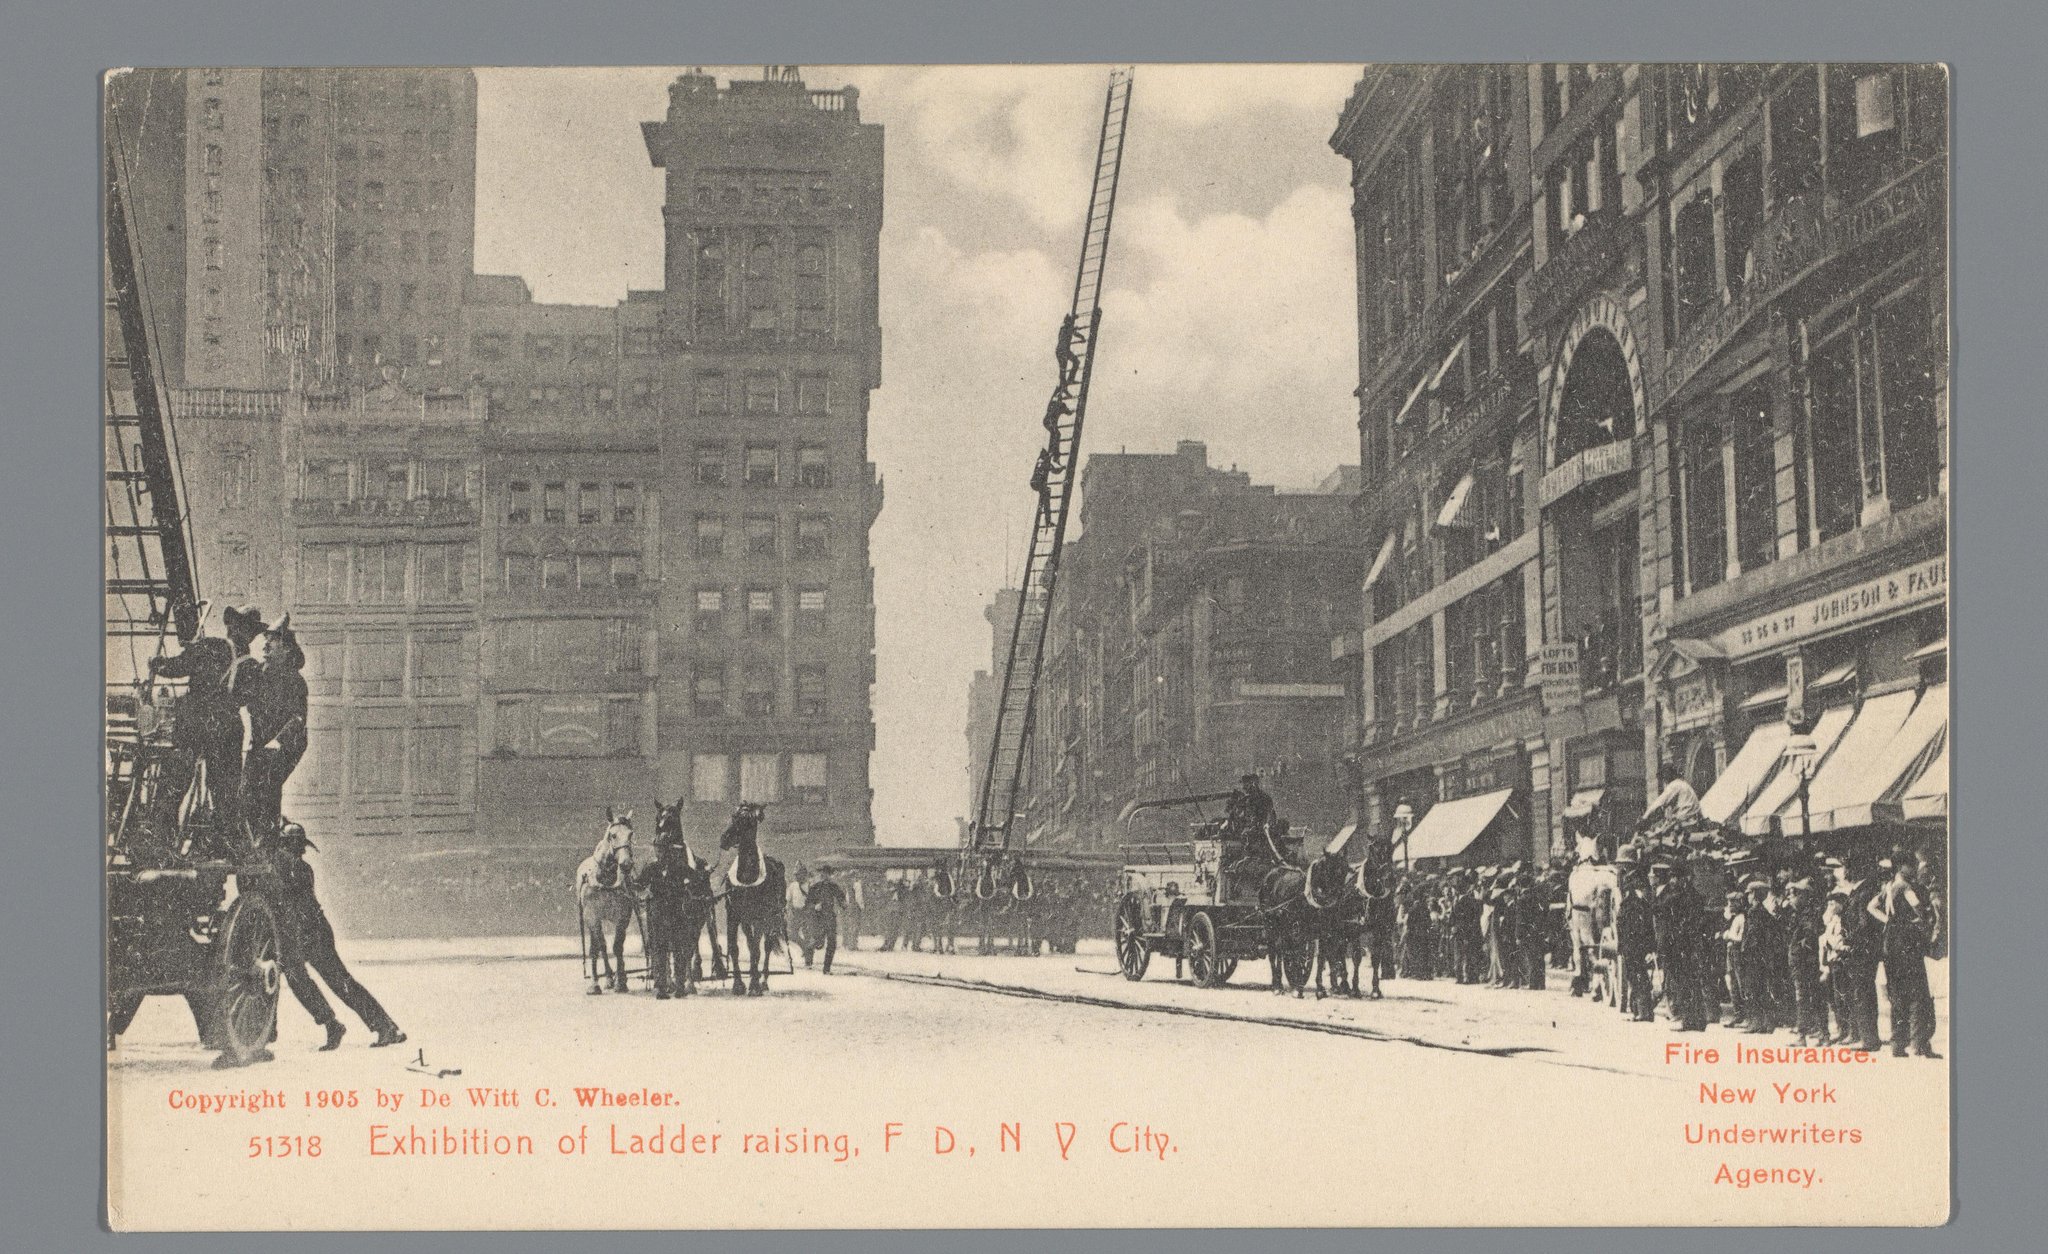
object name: ansichtkaart, prentbriefkaart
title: Reclame voor de Fire Insurance New York Underwriters Agency met een foto van een demonstratie van het uitschuiven van ladders door de brandweer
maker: dewitt c. wheeler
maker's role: fotograaf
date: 1905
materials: photographic support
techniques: photograph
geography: united states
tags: new york (city)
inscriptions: inscription: ‘Copyright 1905 by De Witt C. Wheeler. / 51318 Exhibition of Ladder raising, F D , N Y, City. / Fire Insurance / New York / Underwriters / Agency.’, inscription: ‘The Rotograph Co., N.Y., City. (Germany.)’